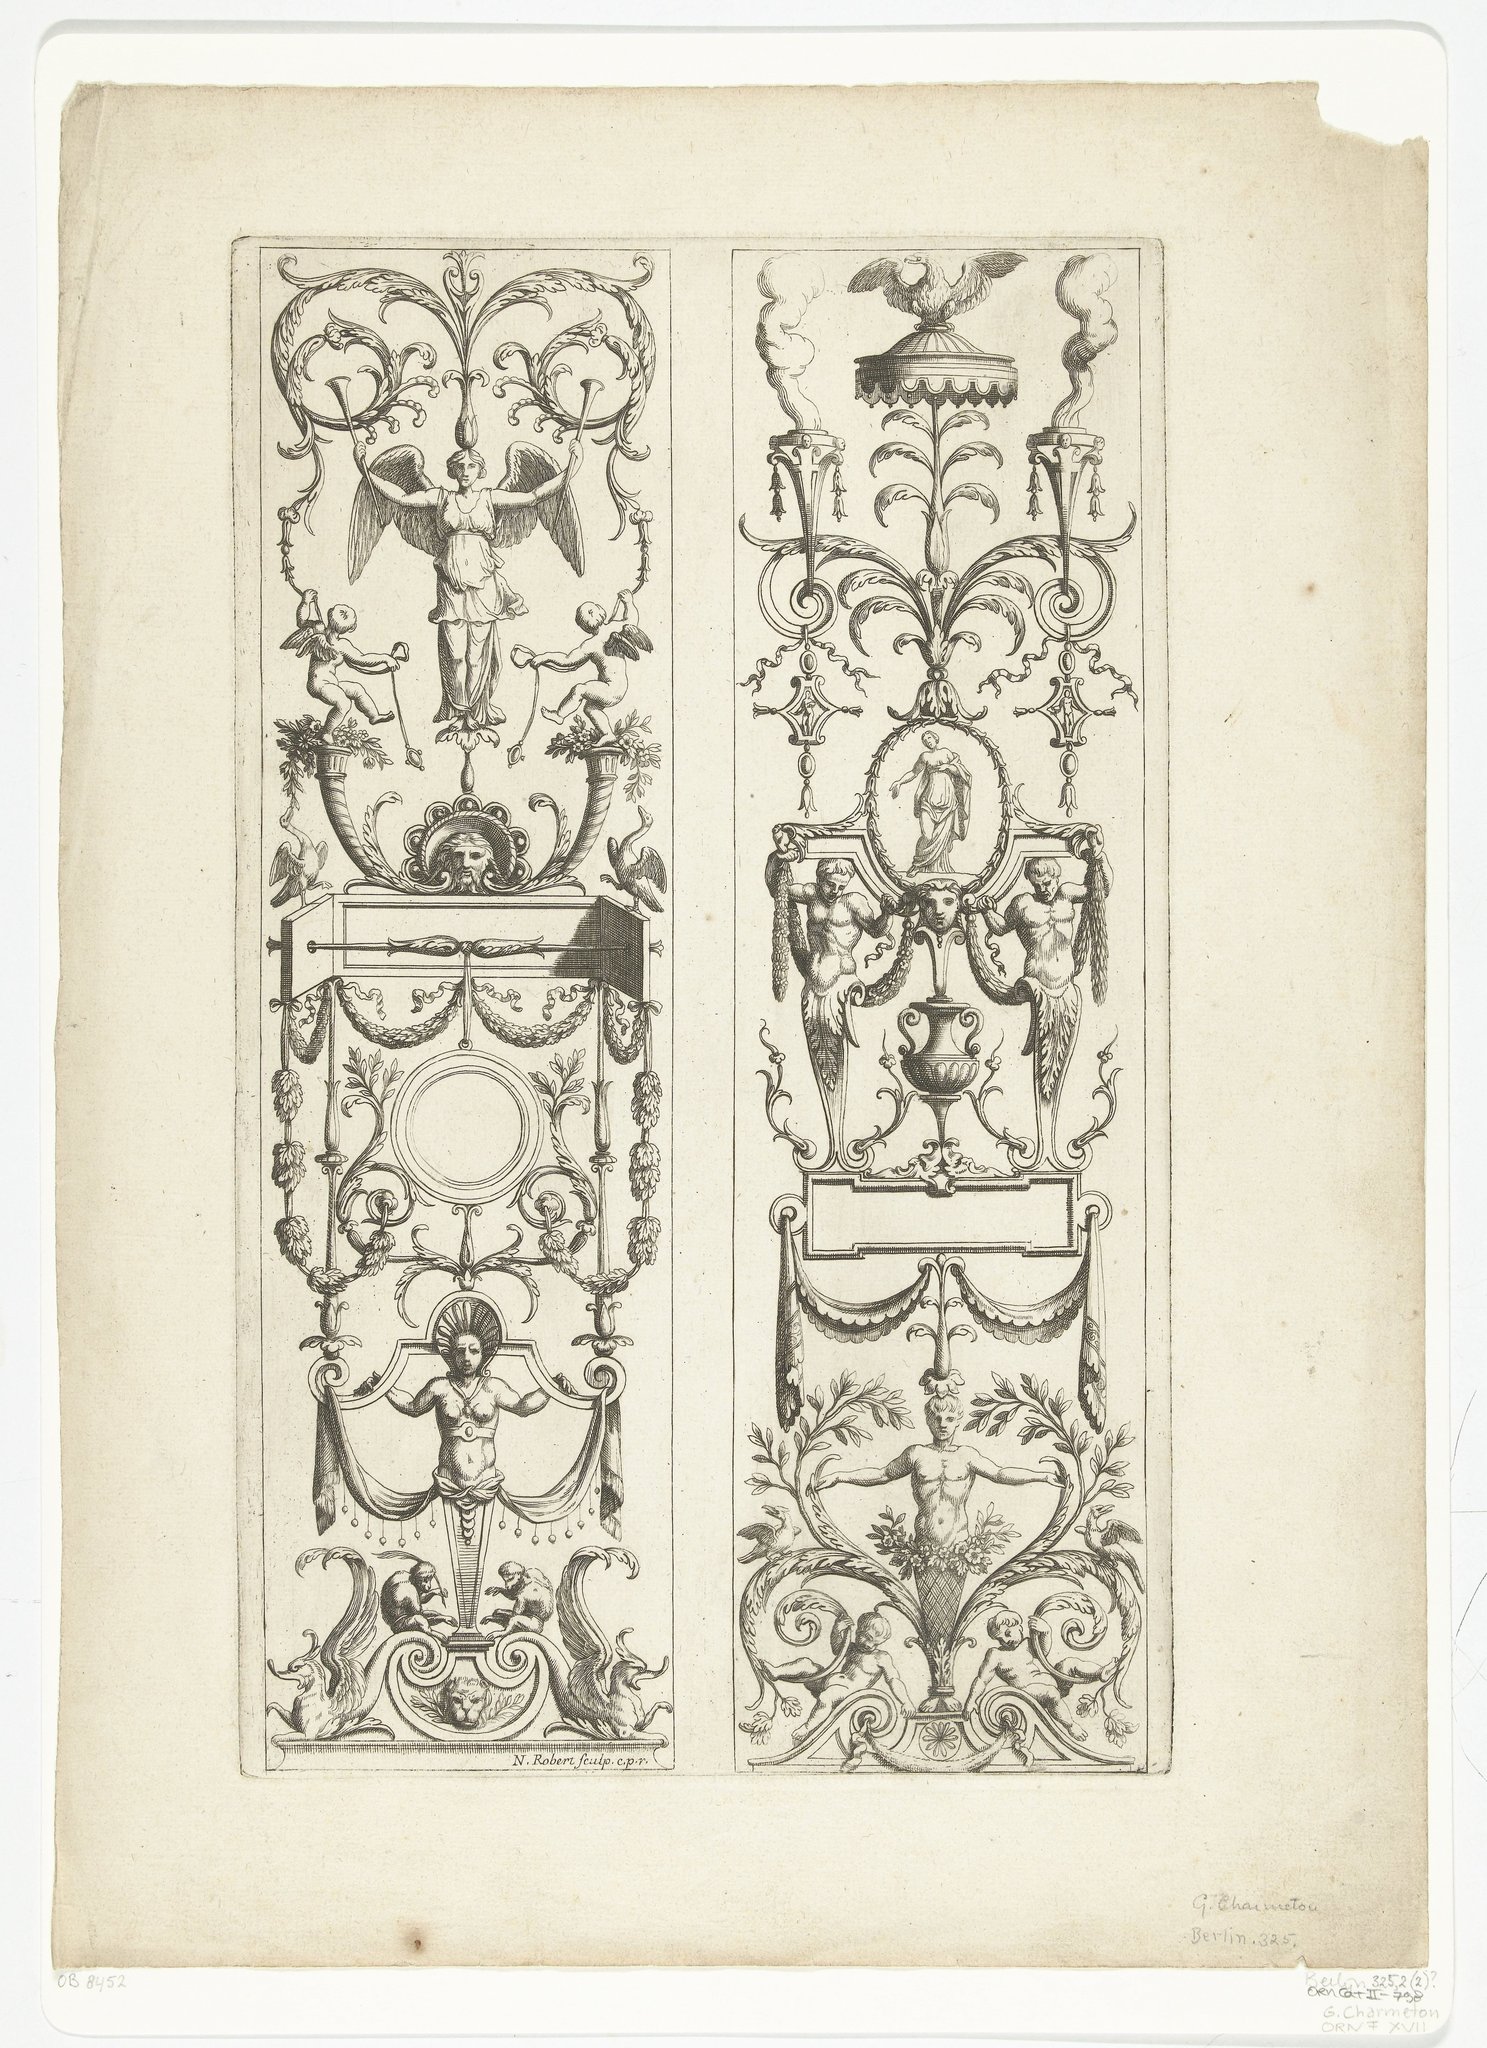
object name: ornament print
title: Ornemens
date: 1676-1680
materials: paper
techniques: engraving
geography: paris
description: Twee verticale panelen naast elkaar met grotesken geïnspireerd op een kandelabermotief. Blad uit serie van 6 bladen, geletterd: a-f.